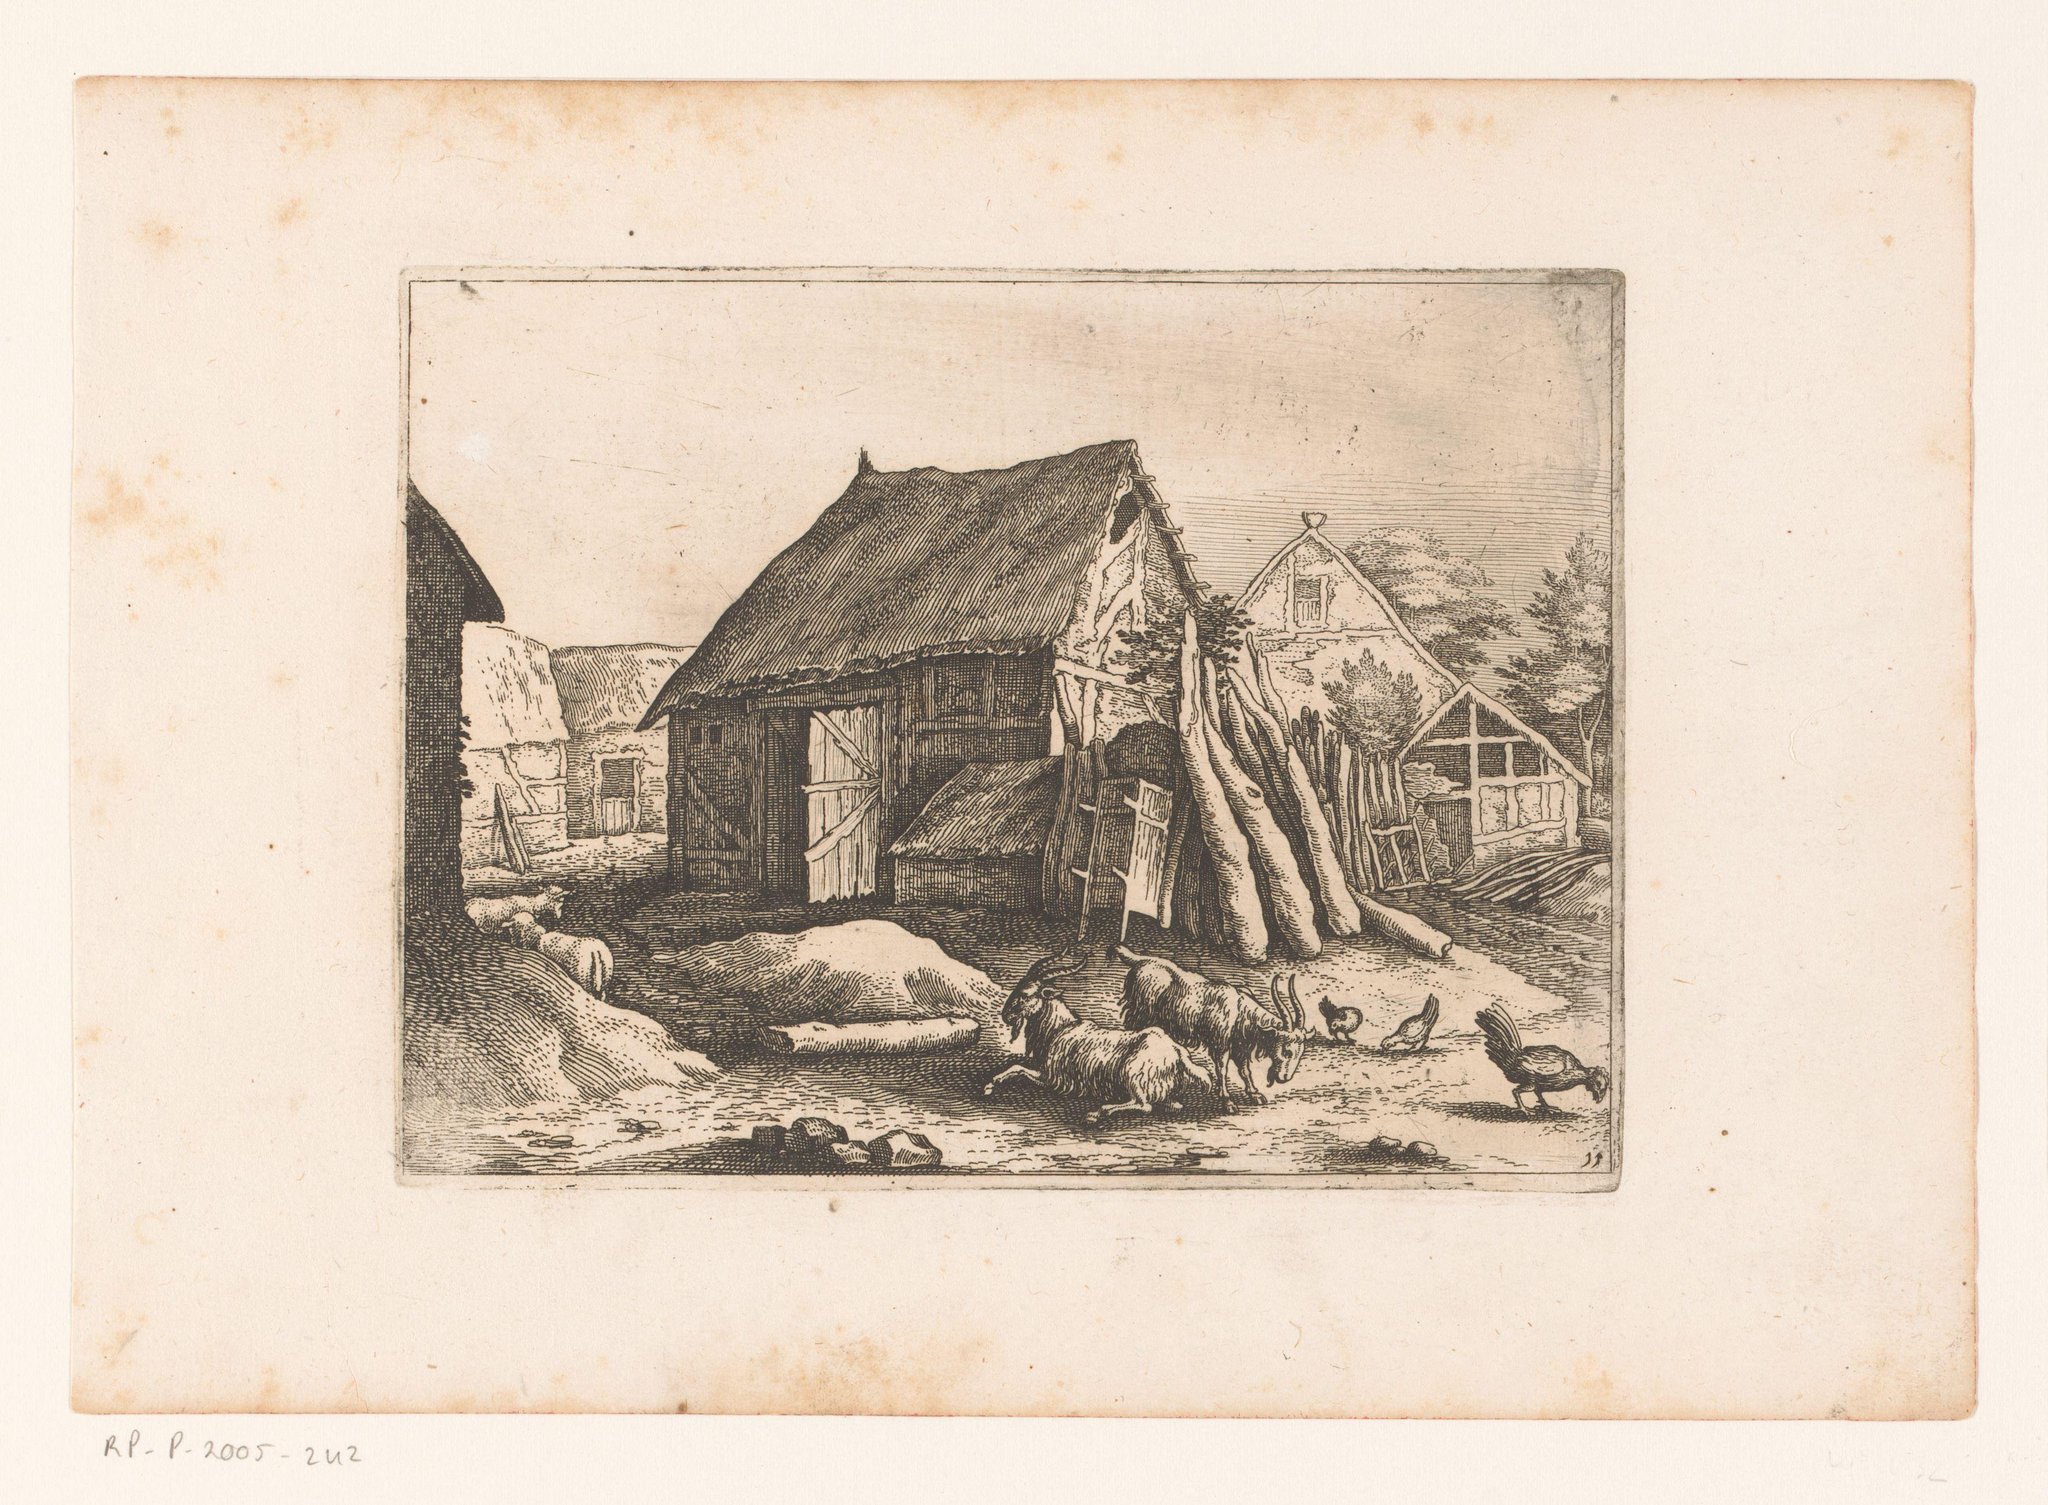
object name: print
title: Landschappen in de Schwalbach-regio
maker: matthäus merian (i)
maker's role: print maker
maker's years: 1593-1650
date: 1620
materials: paper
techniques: etching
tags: village, sheep, fowl (cock, hen, chicken, etc.), goat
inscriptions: collector's mark: Lugt 2760, collector's mark: Lugt 2228